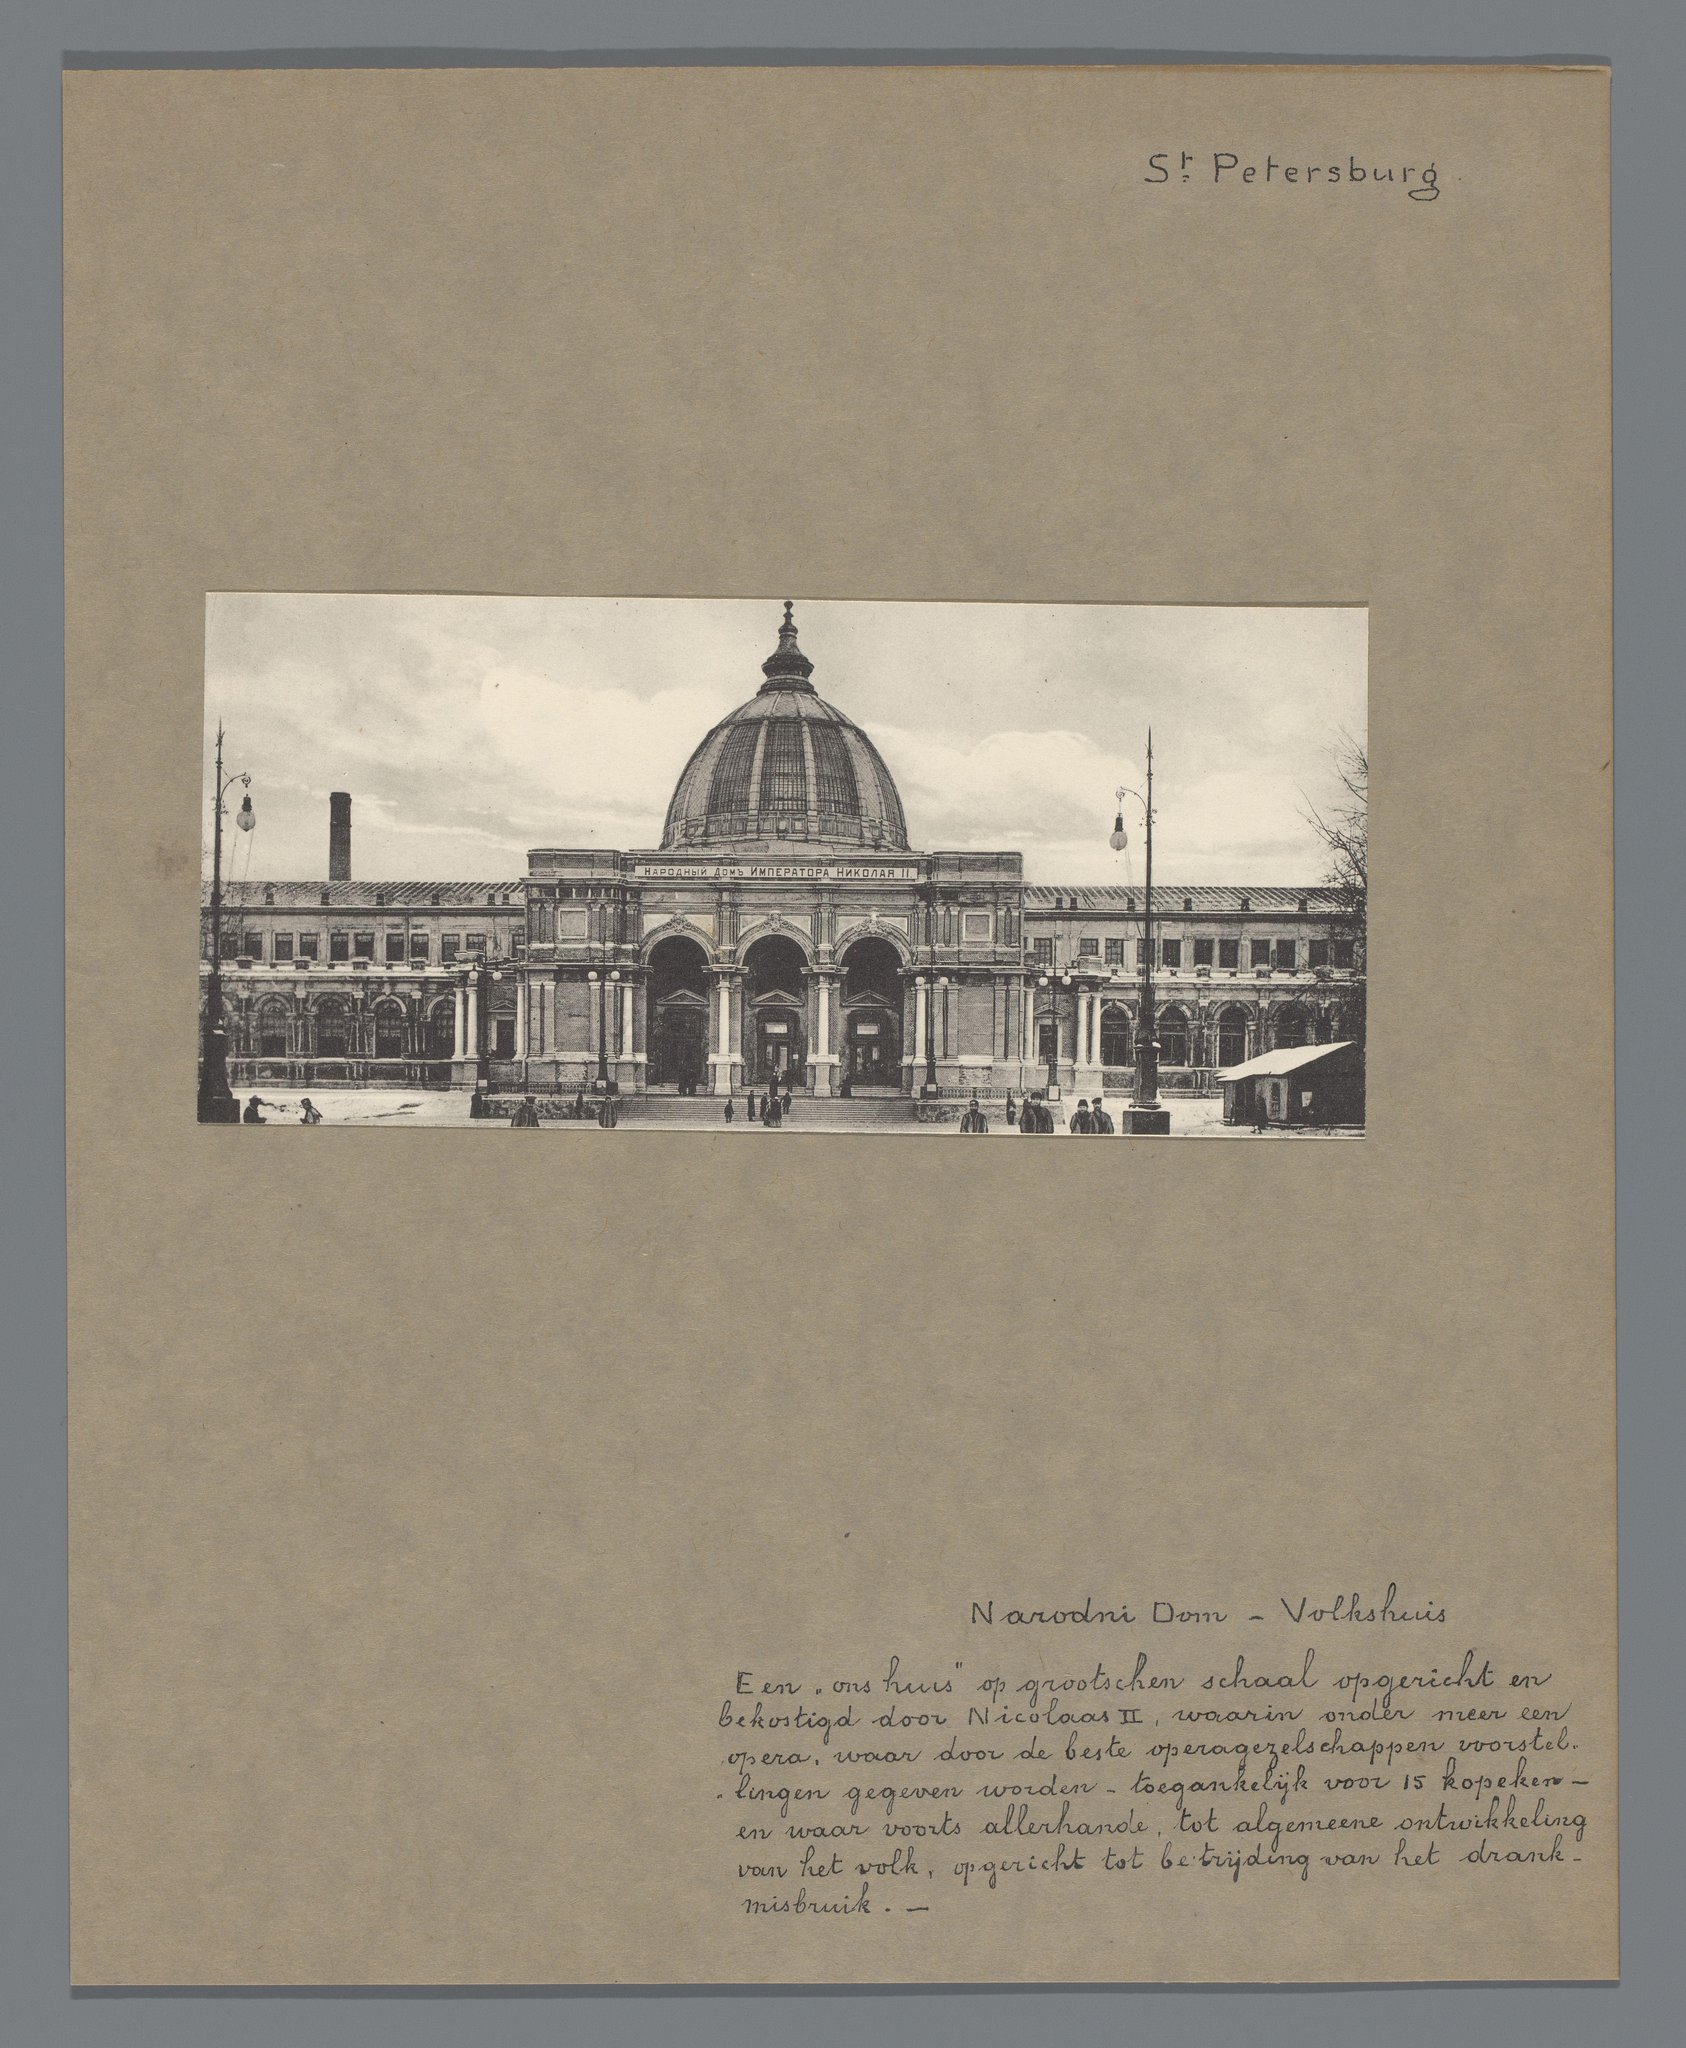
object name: photograph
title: St. Petersburg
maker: Anonymous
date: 1860-1925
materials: photographic support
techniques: photograph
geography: russia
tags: sint-petersburg